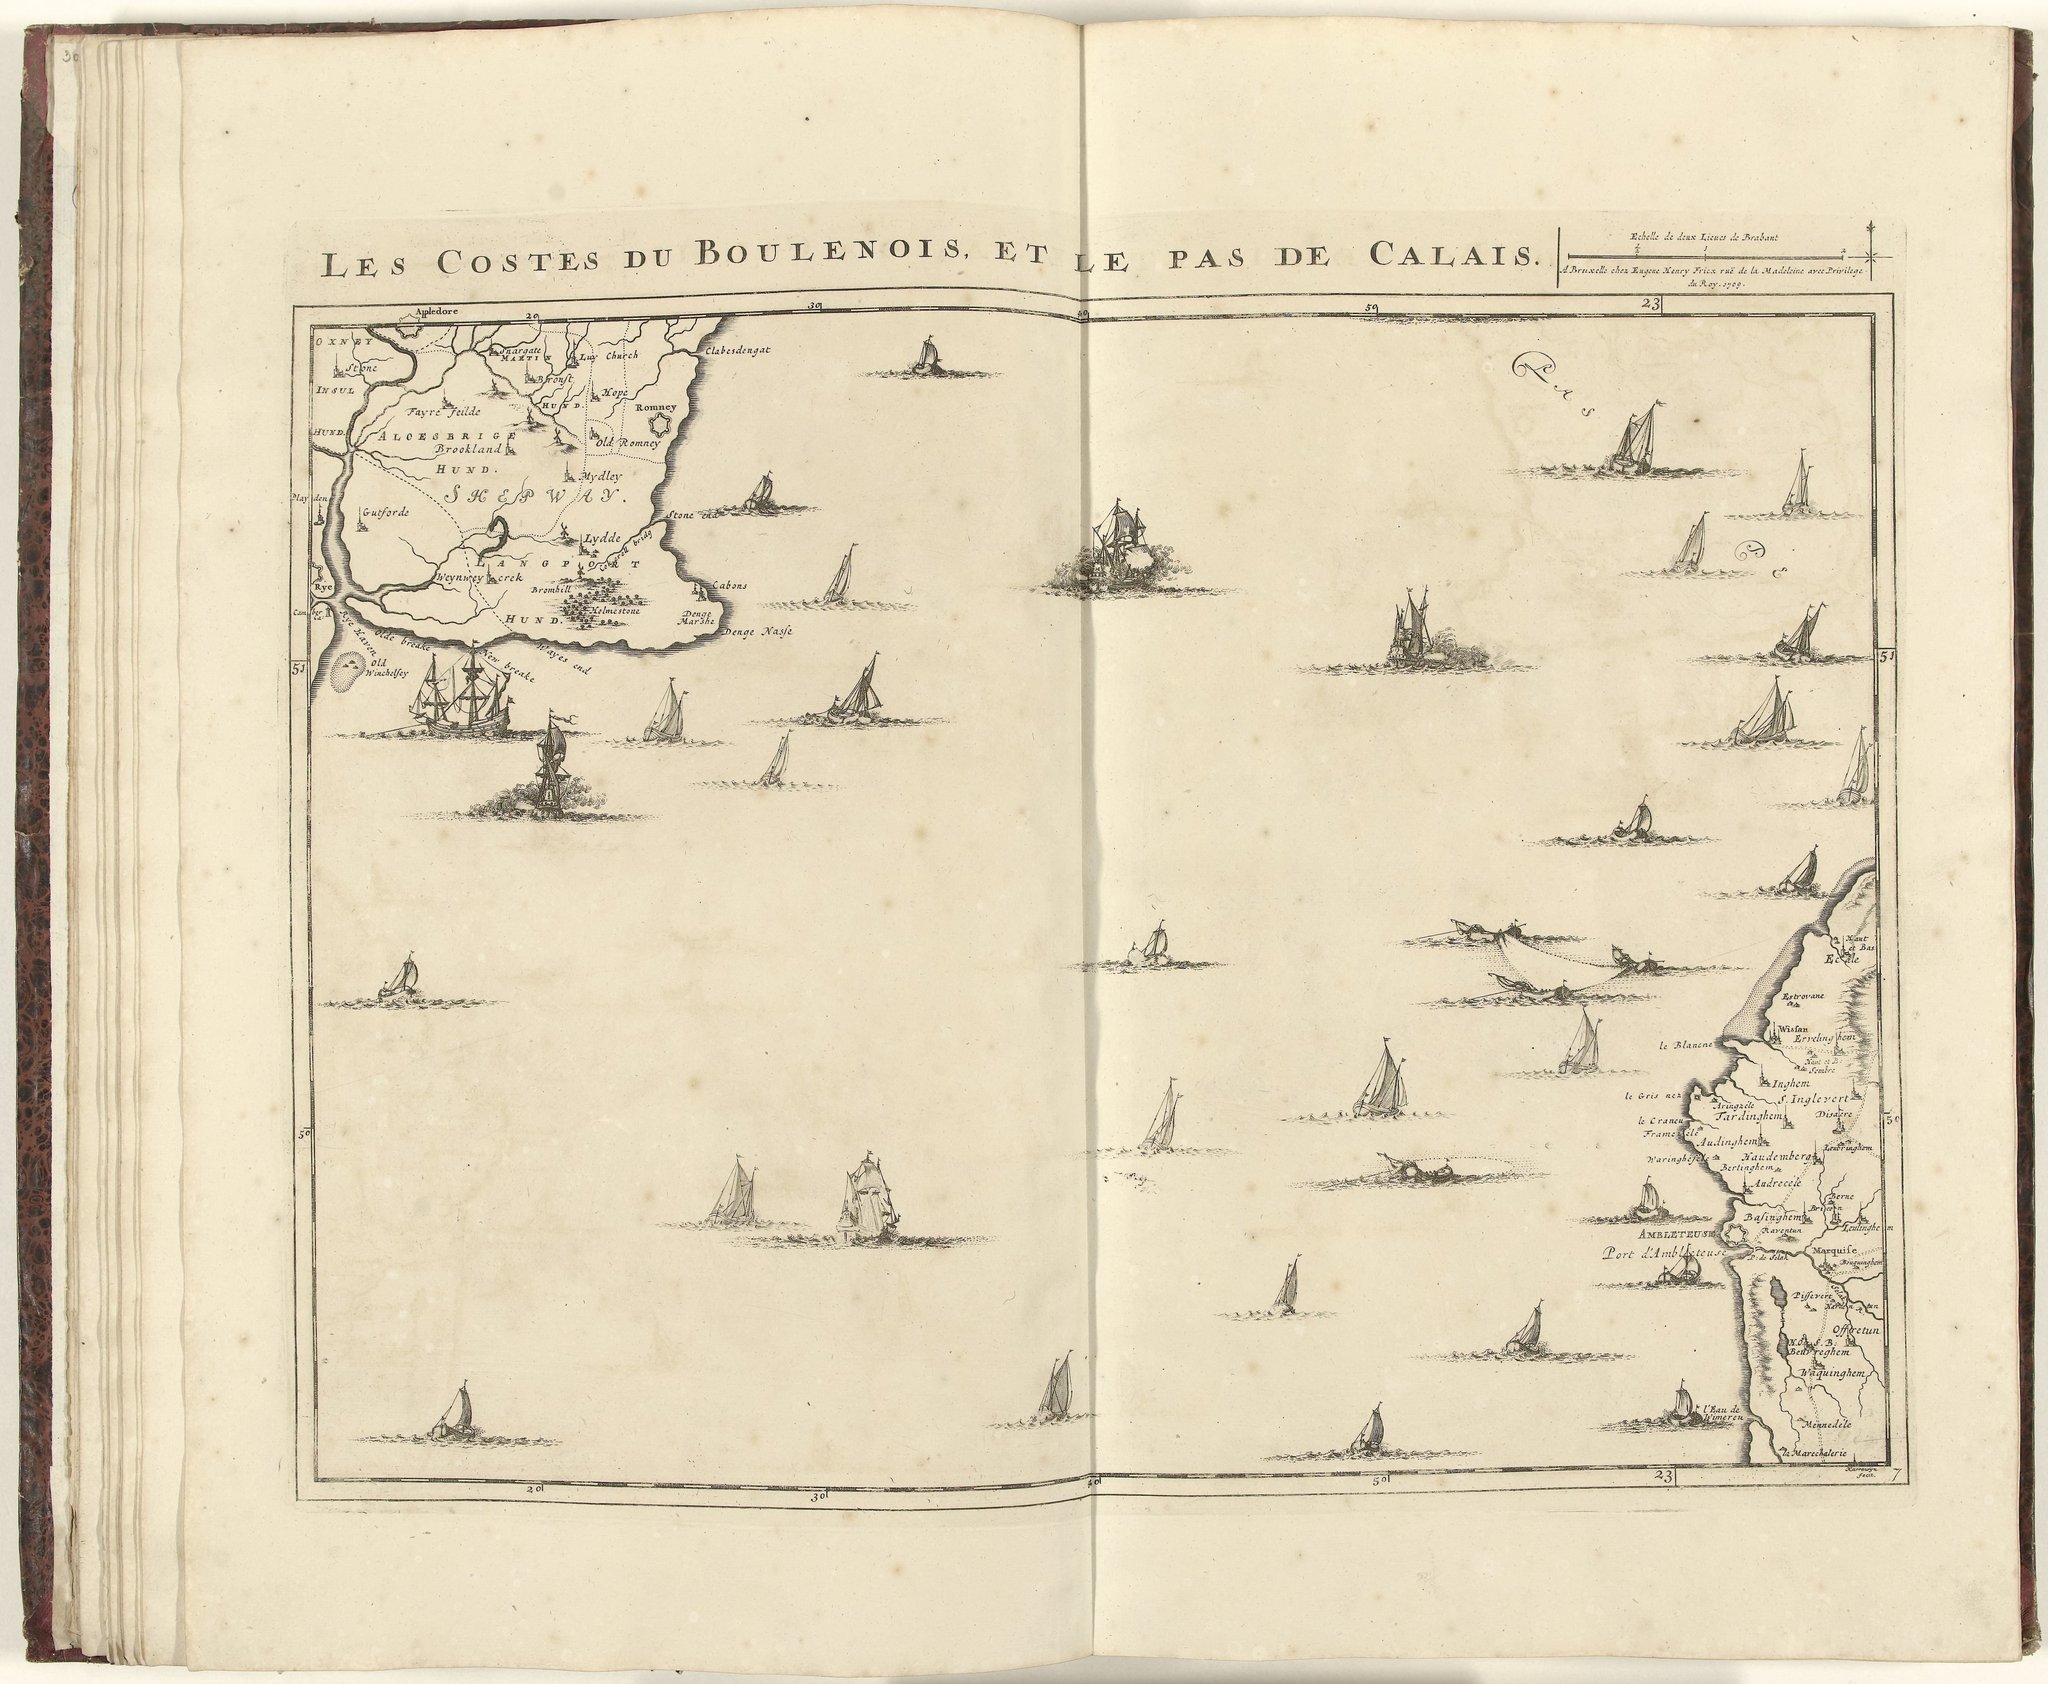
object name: print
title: Les Costes du Boulenois, et le Pas de Calais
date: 1709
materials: paper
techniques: engraving, etching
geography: brussels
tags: marine charts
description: Kaart van het Nauw van Calais, 1709. Onderdeel van een gebundelde verzameling van plannen van veldslagen en steden vermaard in de Spaanse Successieoorlog. Deze plaat behoort tot de eerste 24 platen die samen een zeer grote kaart van de Zuidelijke Nederlanden vormen.